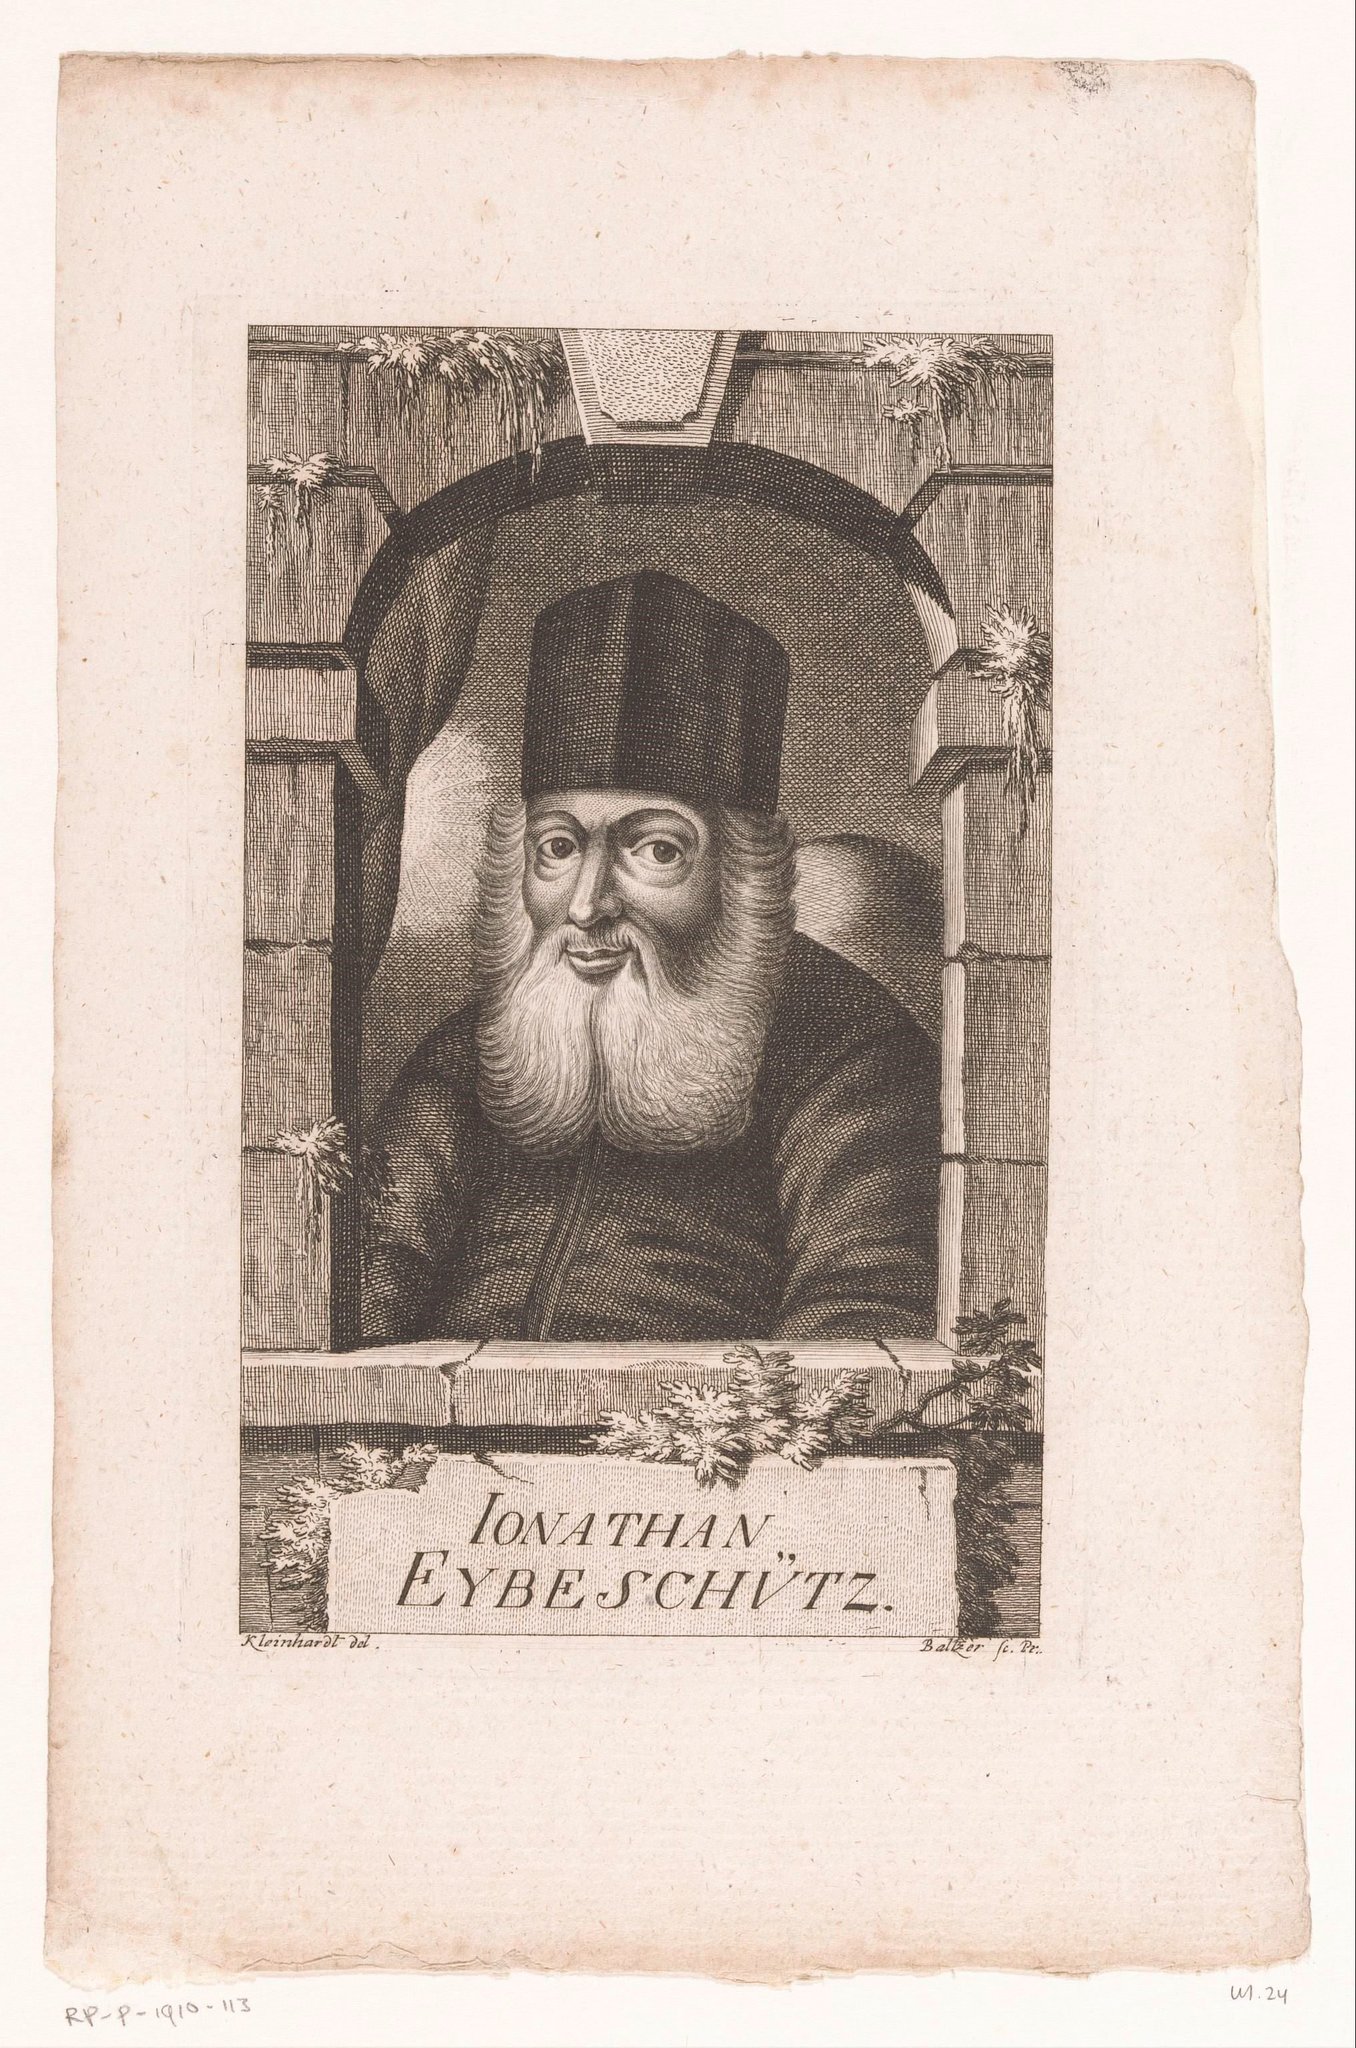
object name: print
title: Portret van Jonathan Eybeschütz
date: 1752-1799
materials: paper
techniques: engraving, etching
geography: prague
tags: historical persons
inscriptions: collector's mark: Lugt 2228